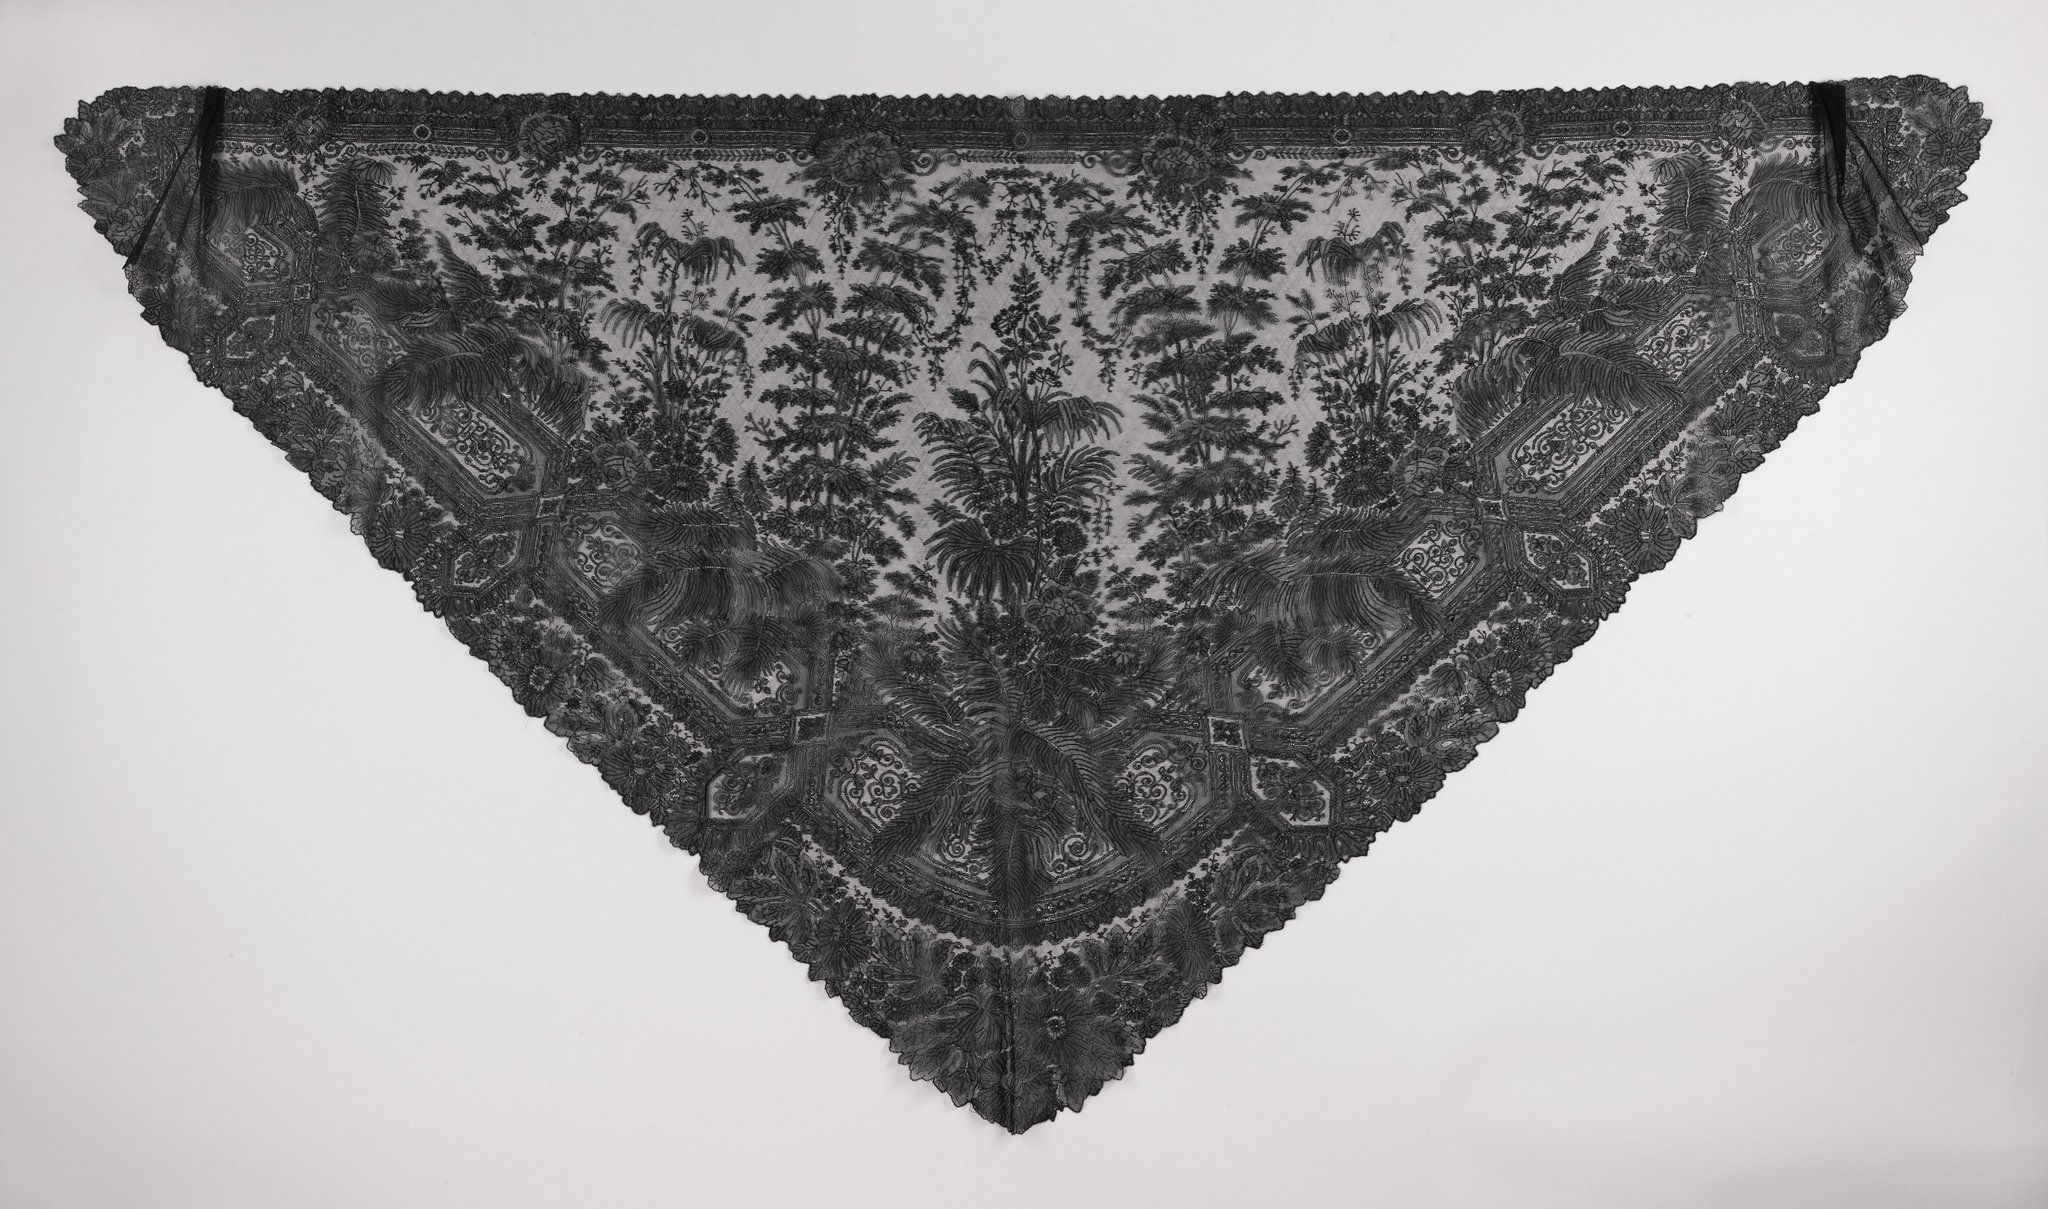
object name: shawl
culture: french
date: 1860-1870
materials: silk